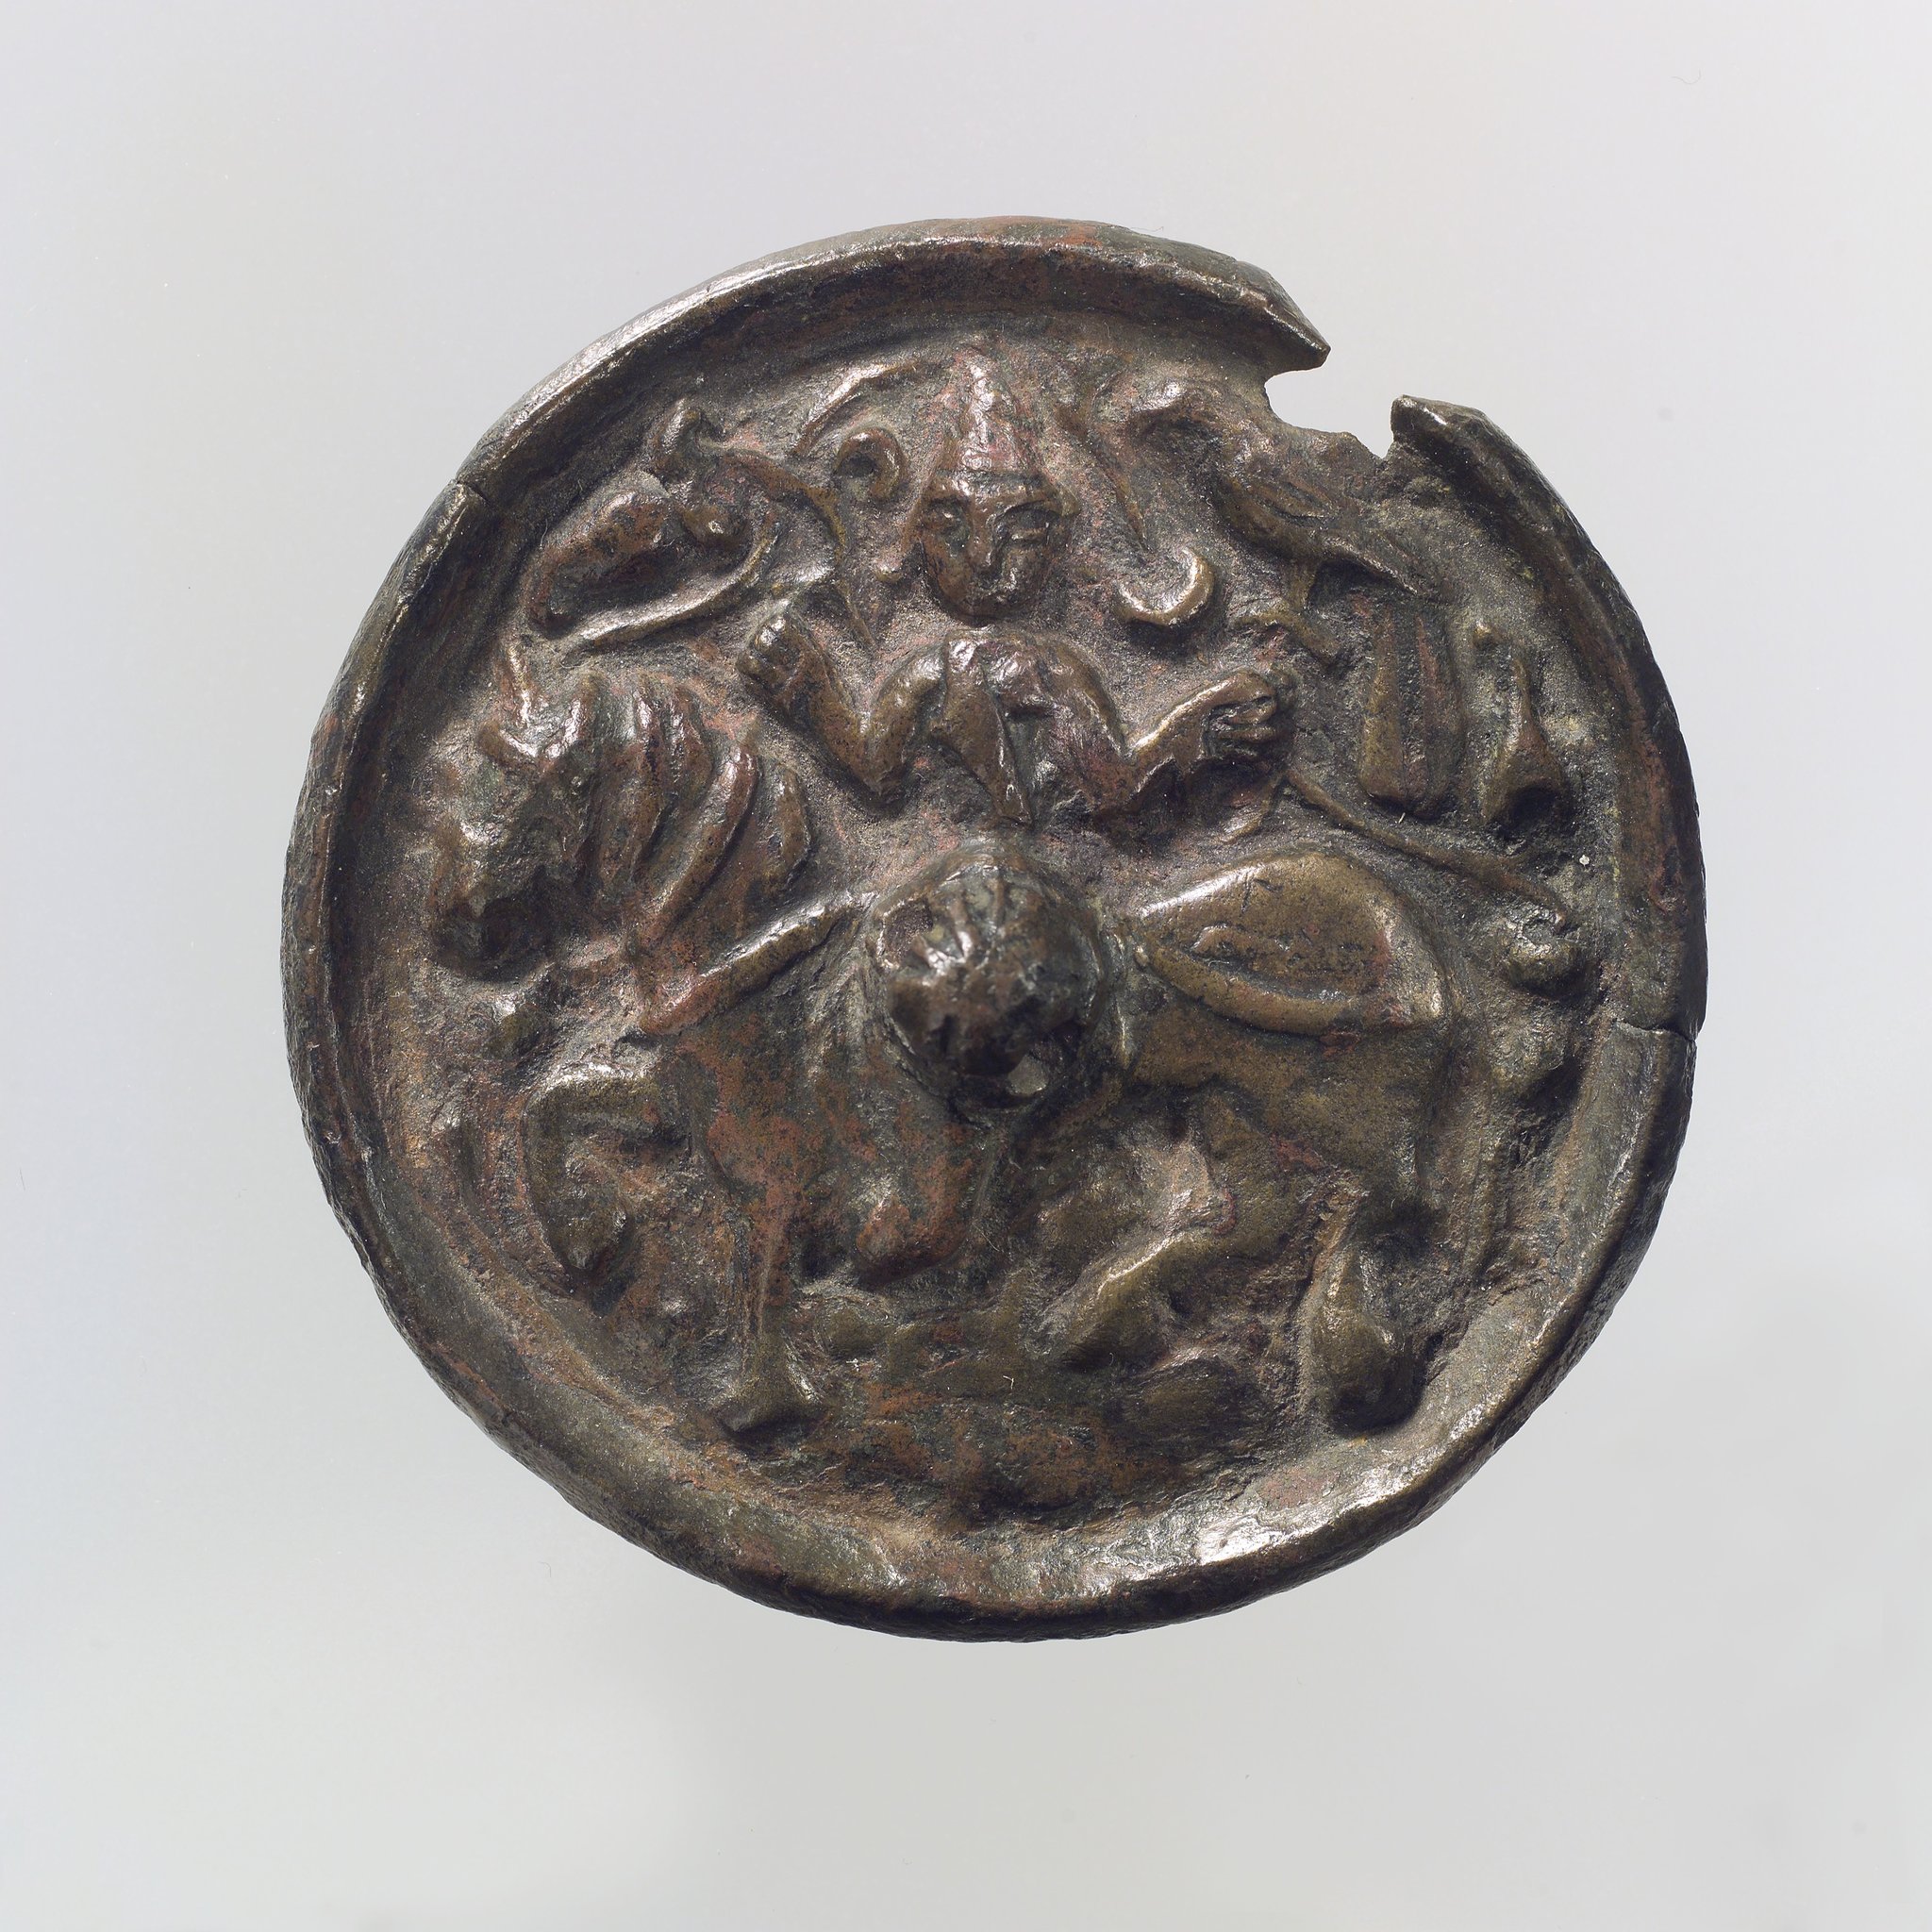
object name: mirror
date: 1001-1200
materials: bronze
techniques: casting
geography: iran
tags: eagles,horses